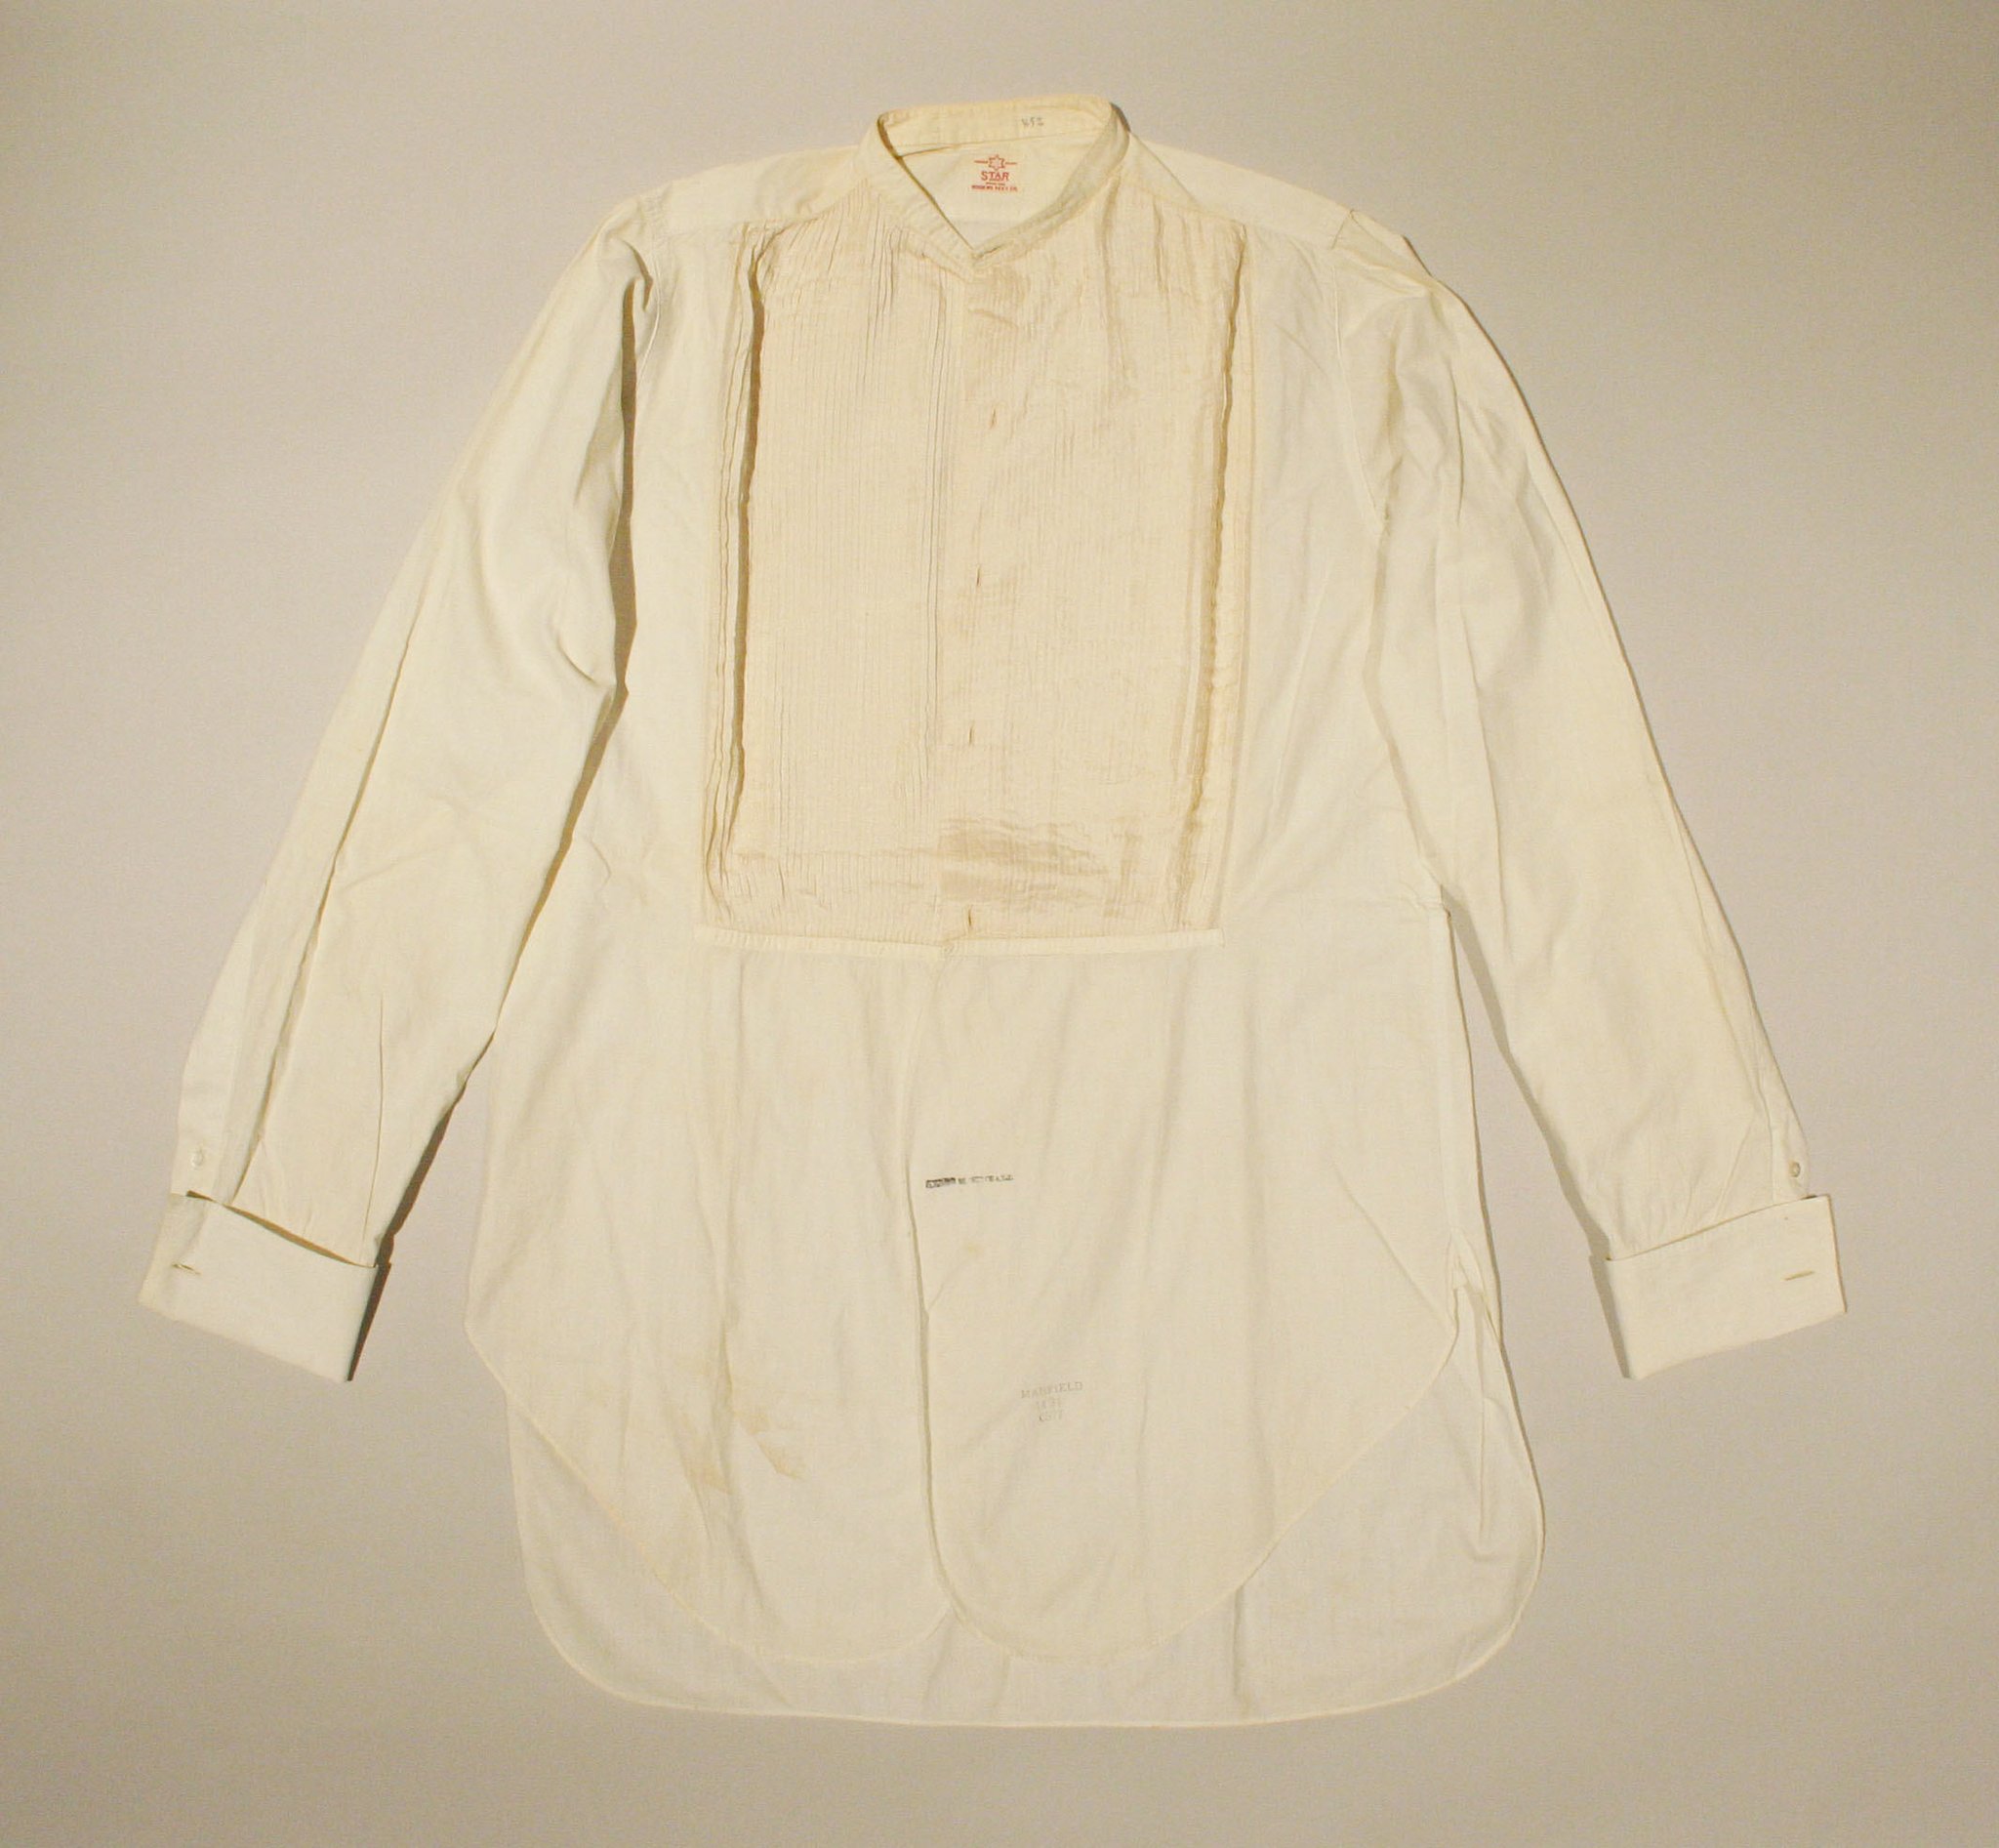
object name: dress shirt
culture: american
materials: linen, silk